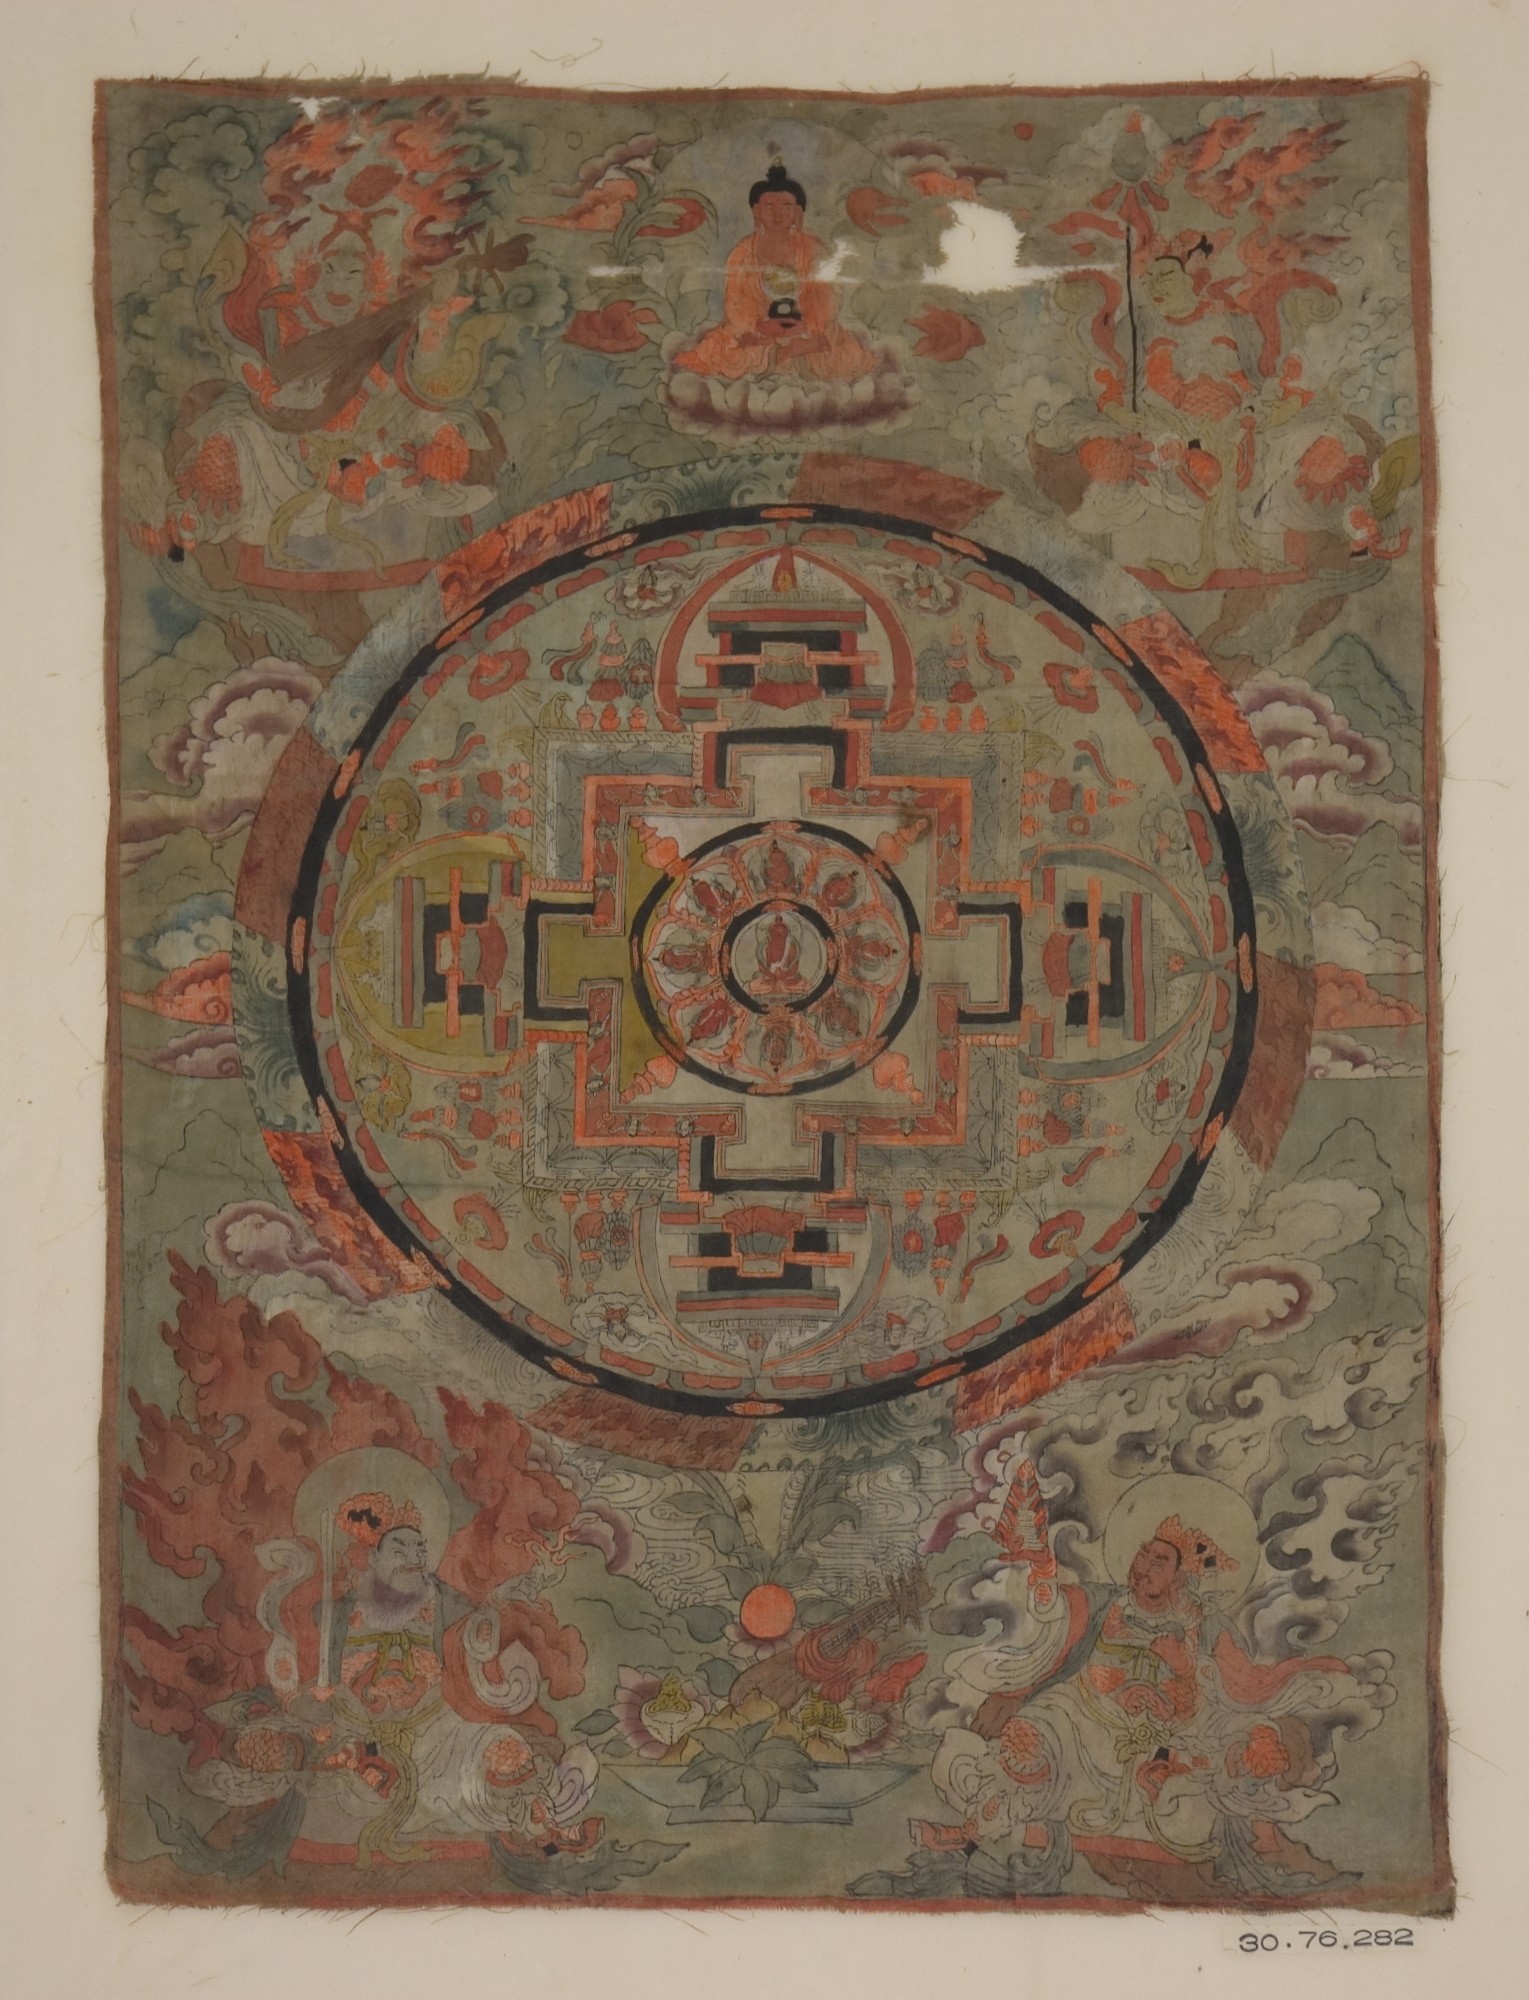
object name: thangka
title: Buddha Surrounded By Bodhisattvas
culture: tibetan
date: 1801-1900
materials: silk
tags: buddhism,bodhisattvas,buddha